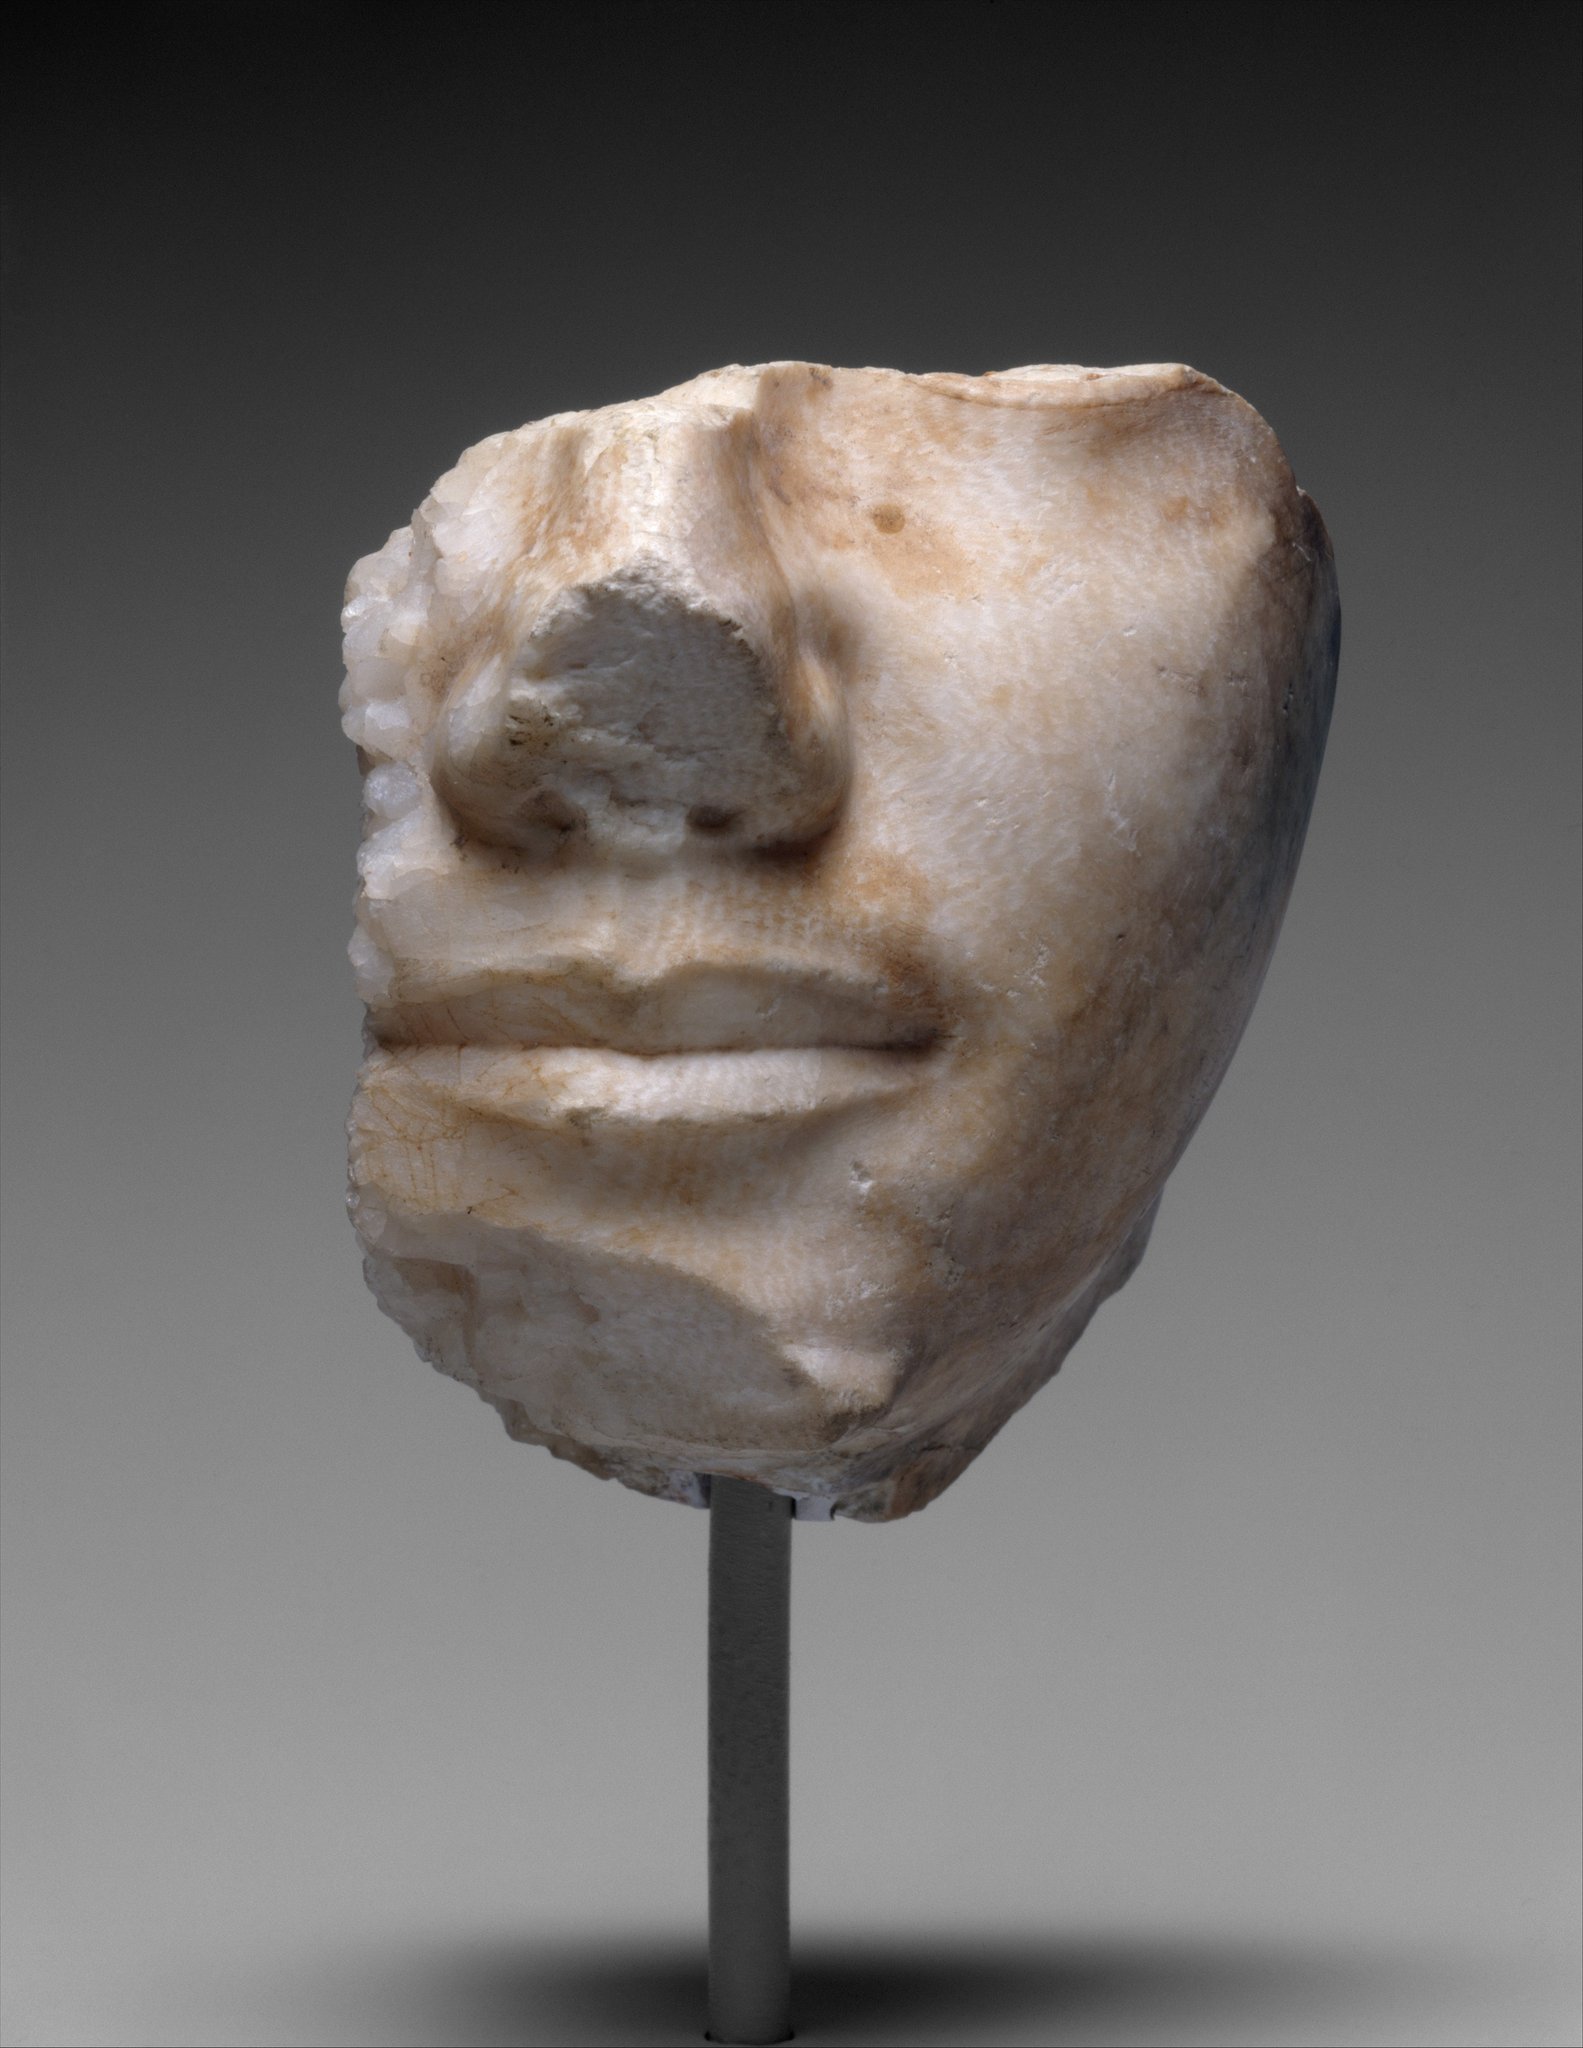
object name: head fragment, king khafre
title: Fragmentary Face of King Khafre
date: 2520-2494 BCE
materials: stone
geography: memphite region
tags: faces,men